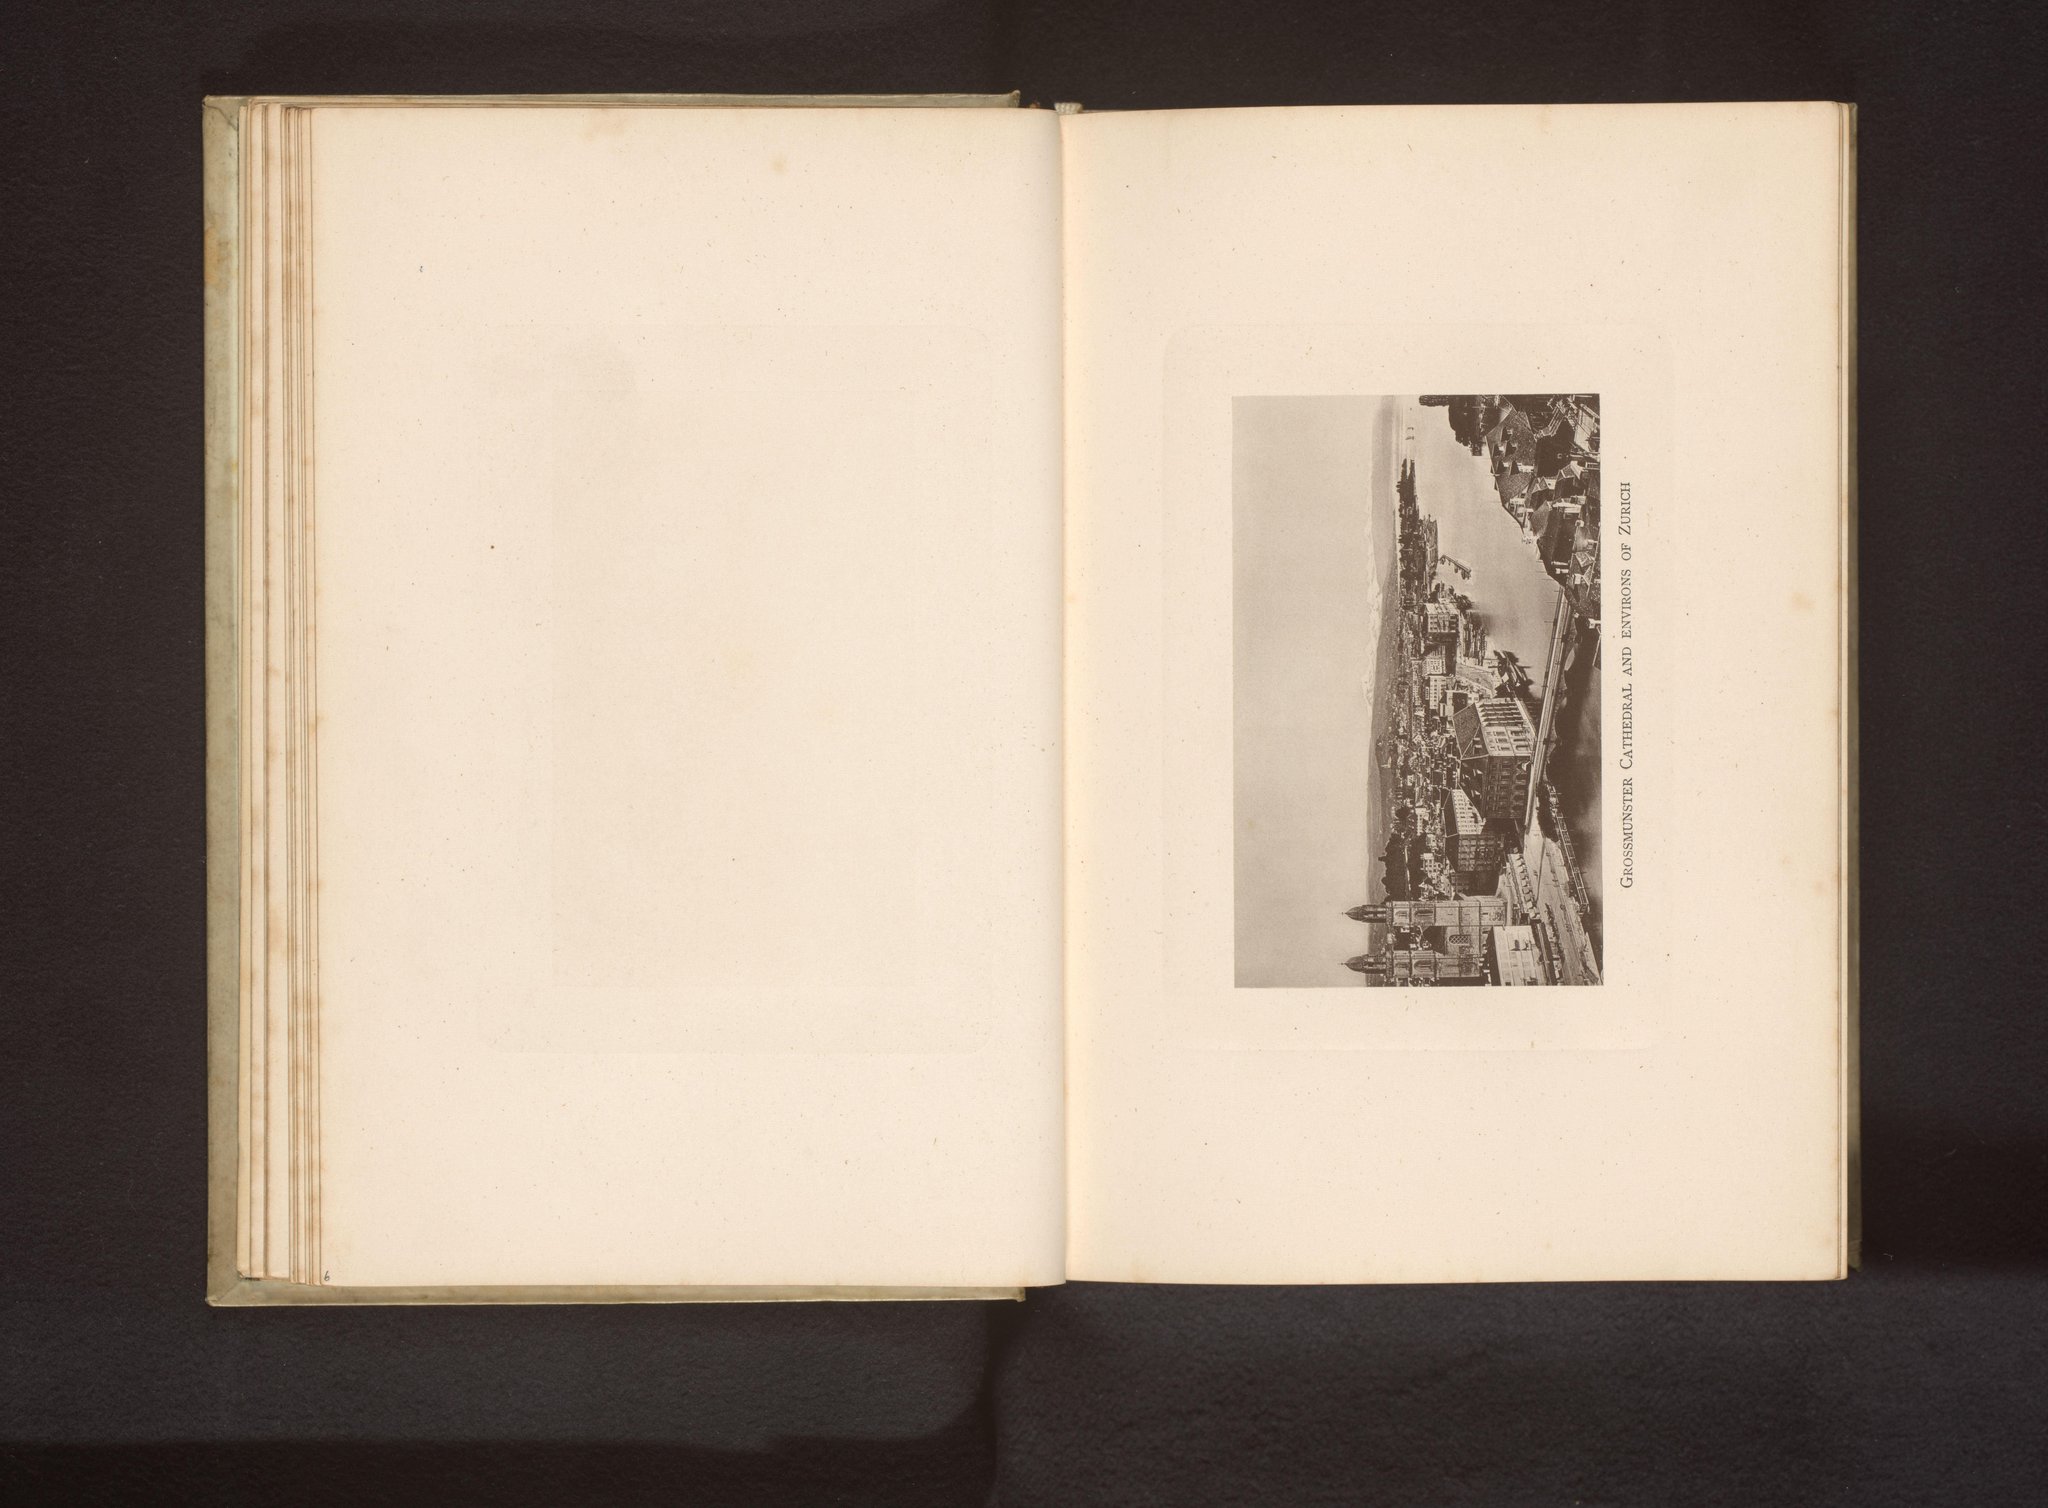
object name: photomechanical print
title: Grossmunster Cathedral and environs of Zurich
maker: Anonymous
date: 1874-1884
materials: paper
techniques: photograph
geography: zurich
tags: city-view in general; 'veduta', church (exterior)